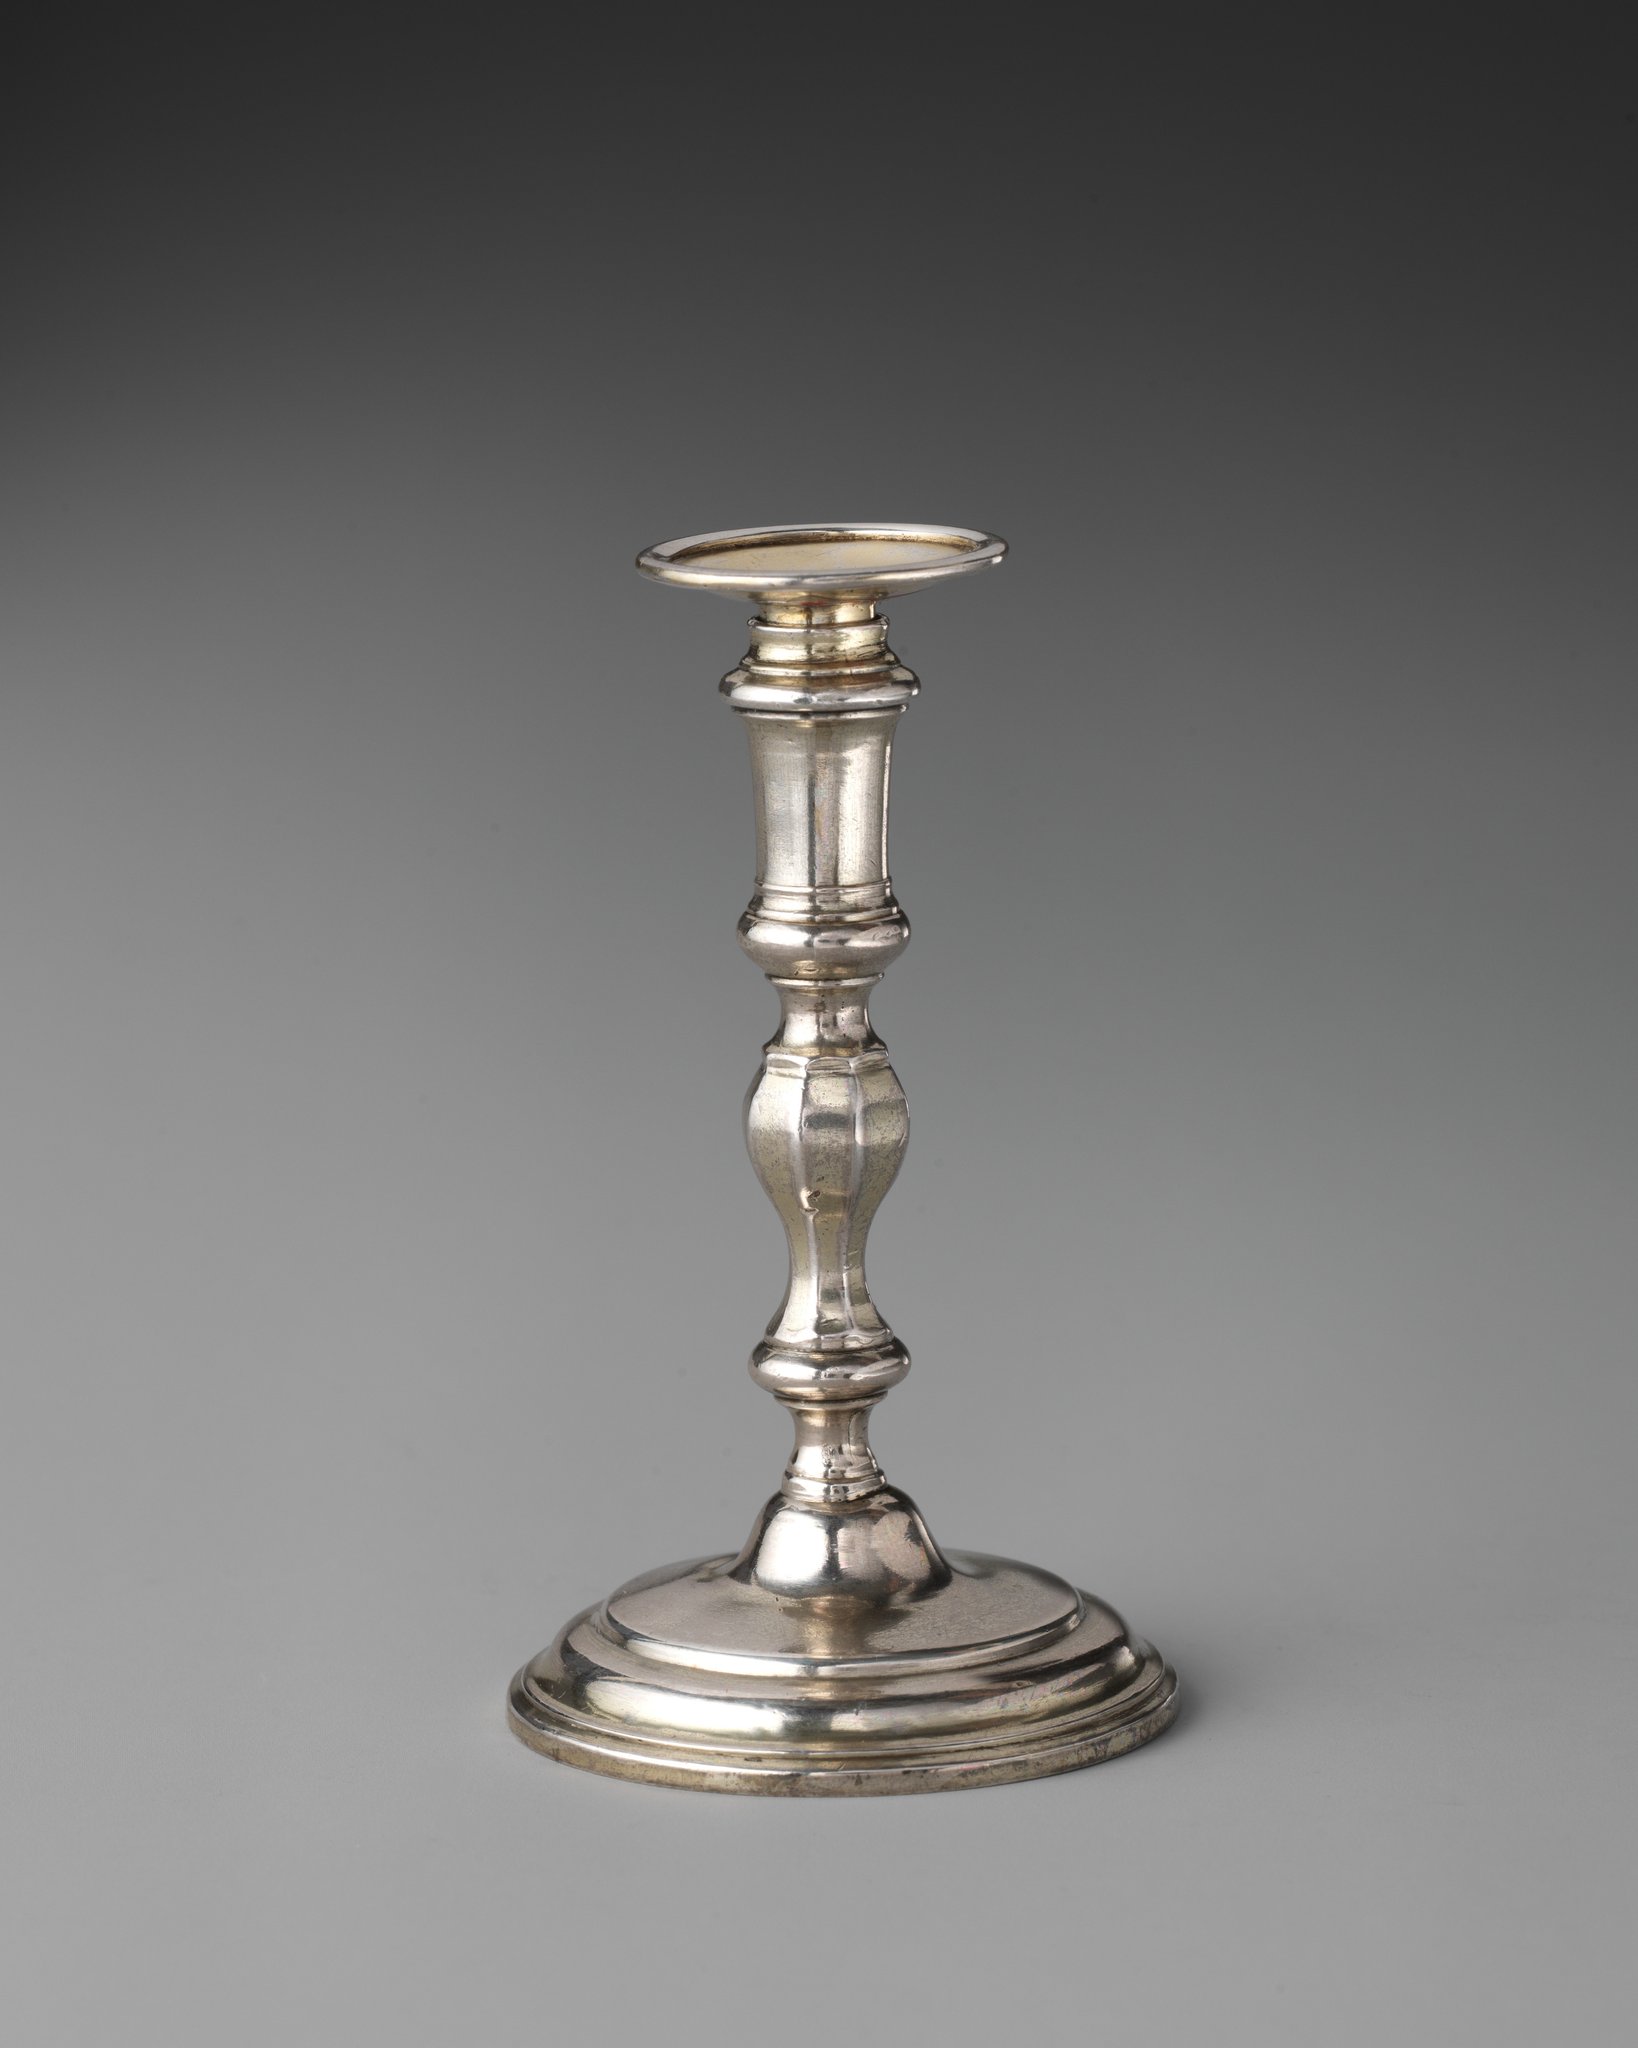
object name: candlestick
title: Miniature candlestick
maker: josiah daniel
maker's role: maker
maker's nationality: british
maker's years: 1712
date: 1719-1720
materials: silver